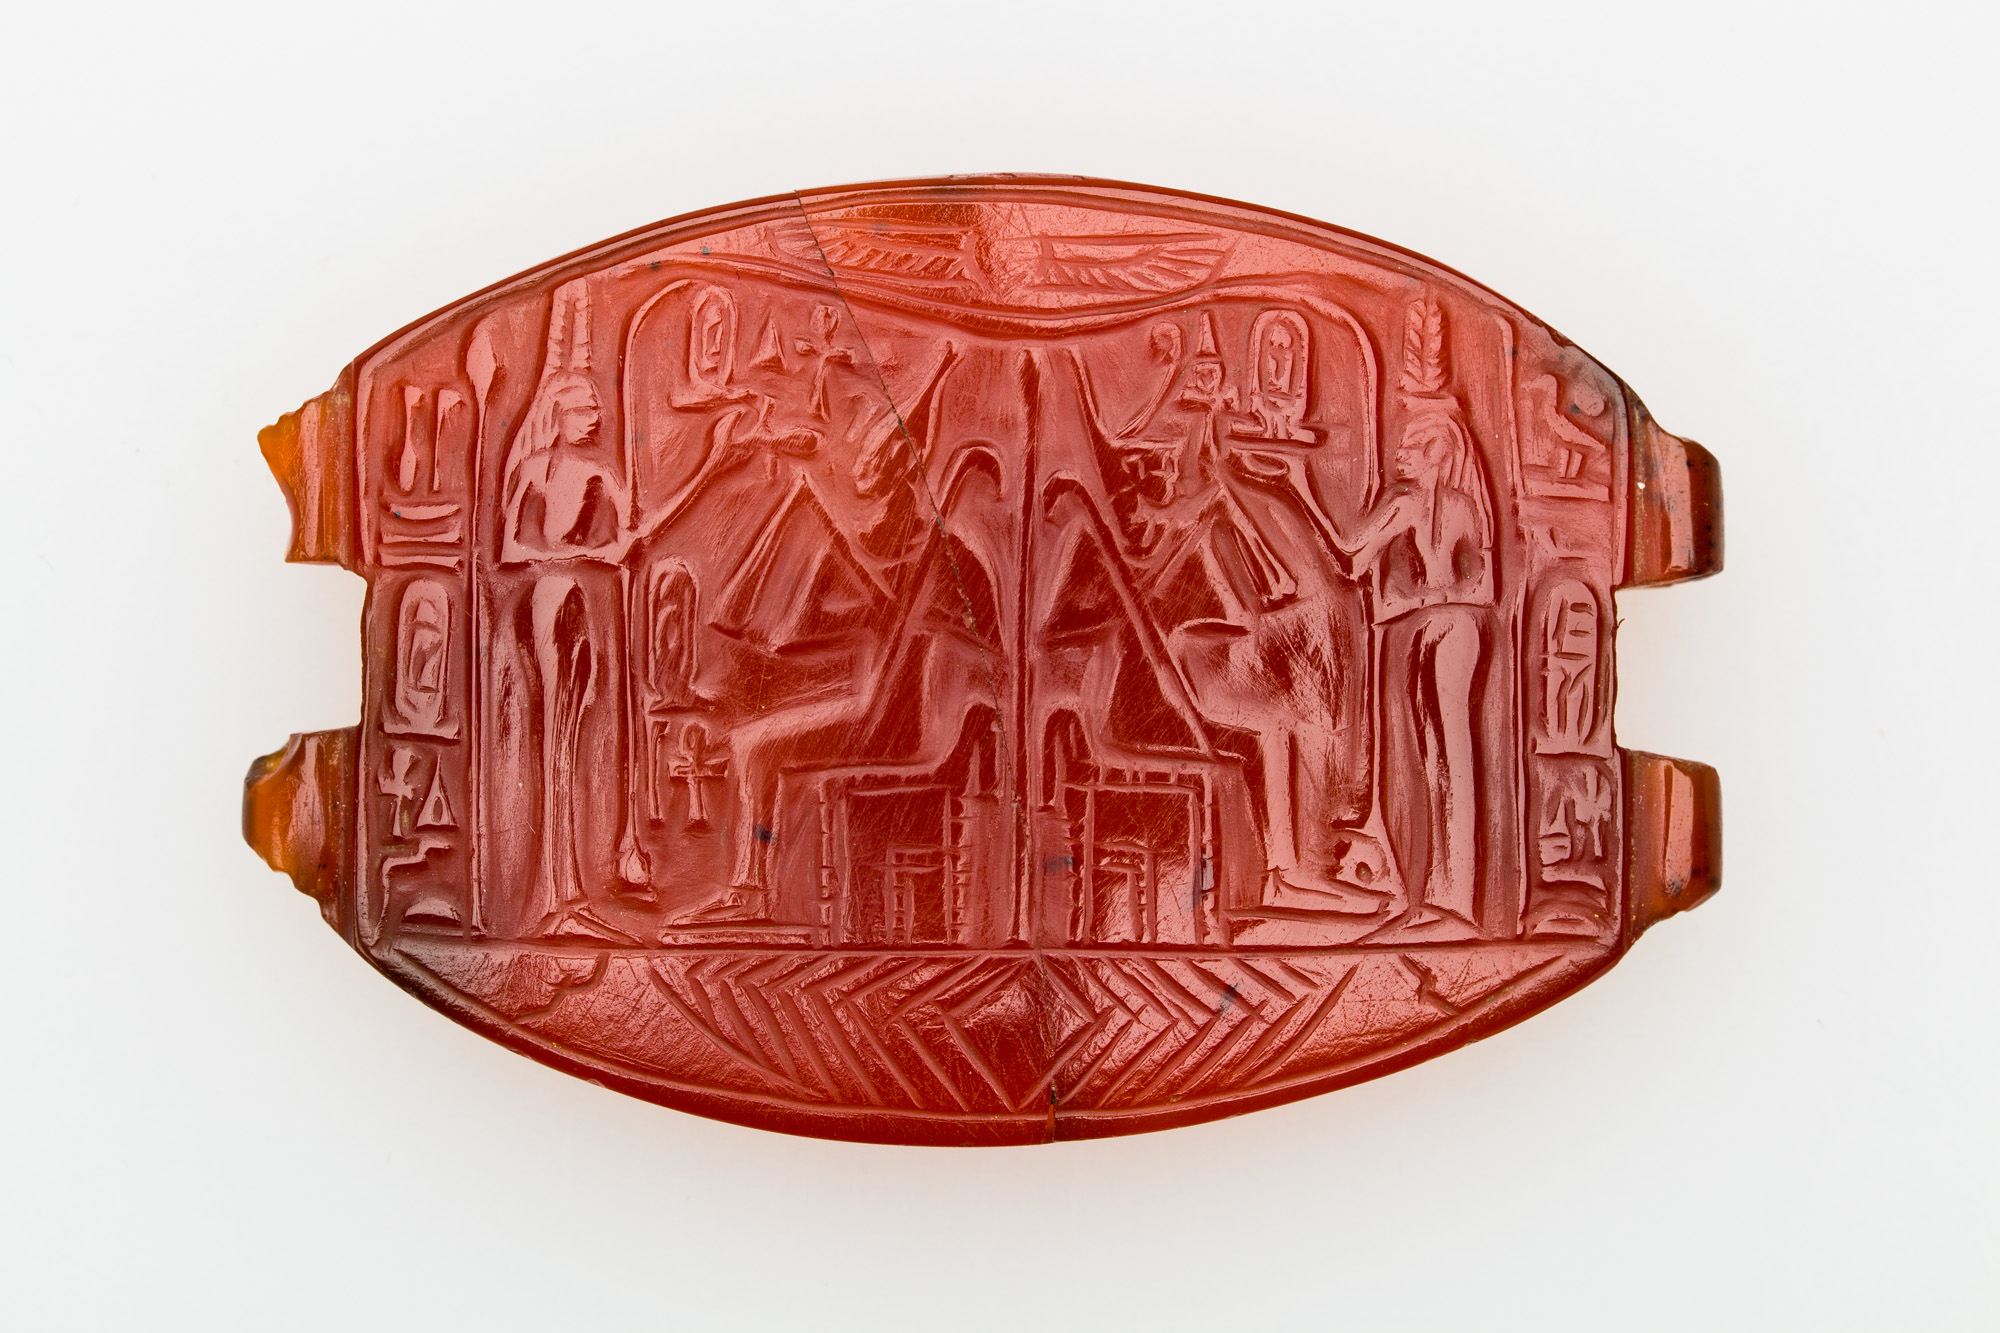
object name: plaque, jewelry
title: Carved Plaque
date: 1390-1352 BCE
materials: gemstone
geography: egypt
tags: human figures